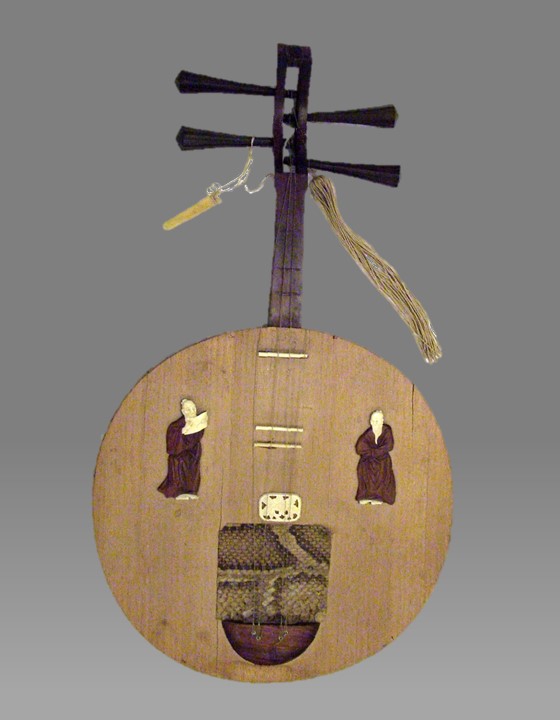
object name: gekkin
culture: japanese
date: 1801-1900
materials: ivory, silk, skin, wood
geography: japan